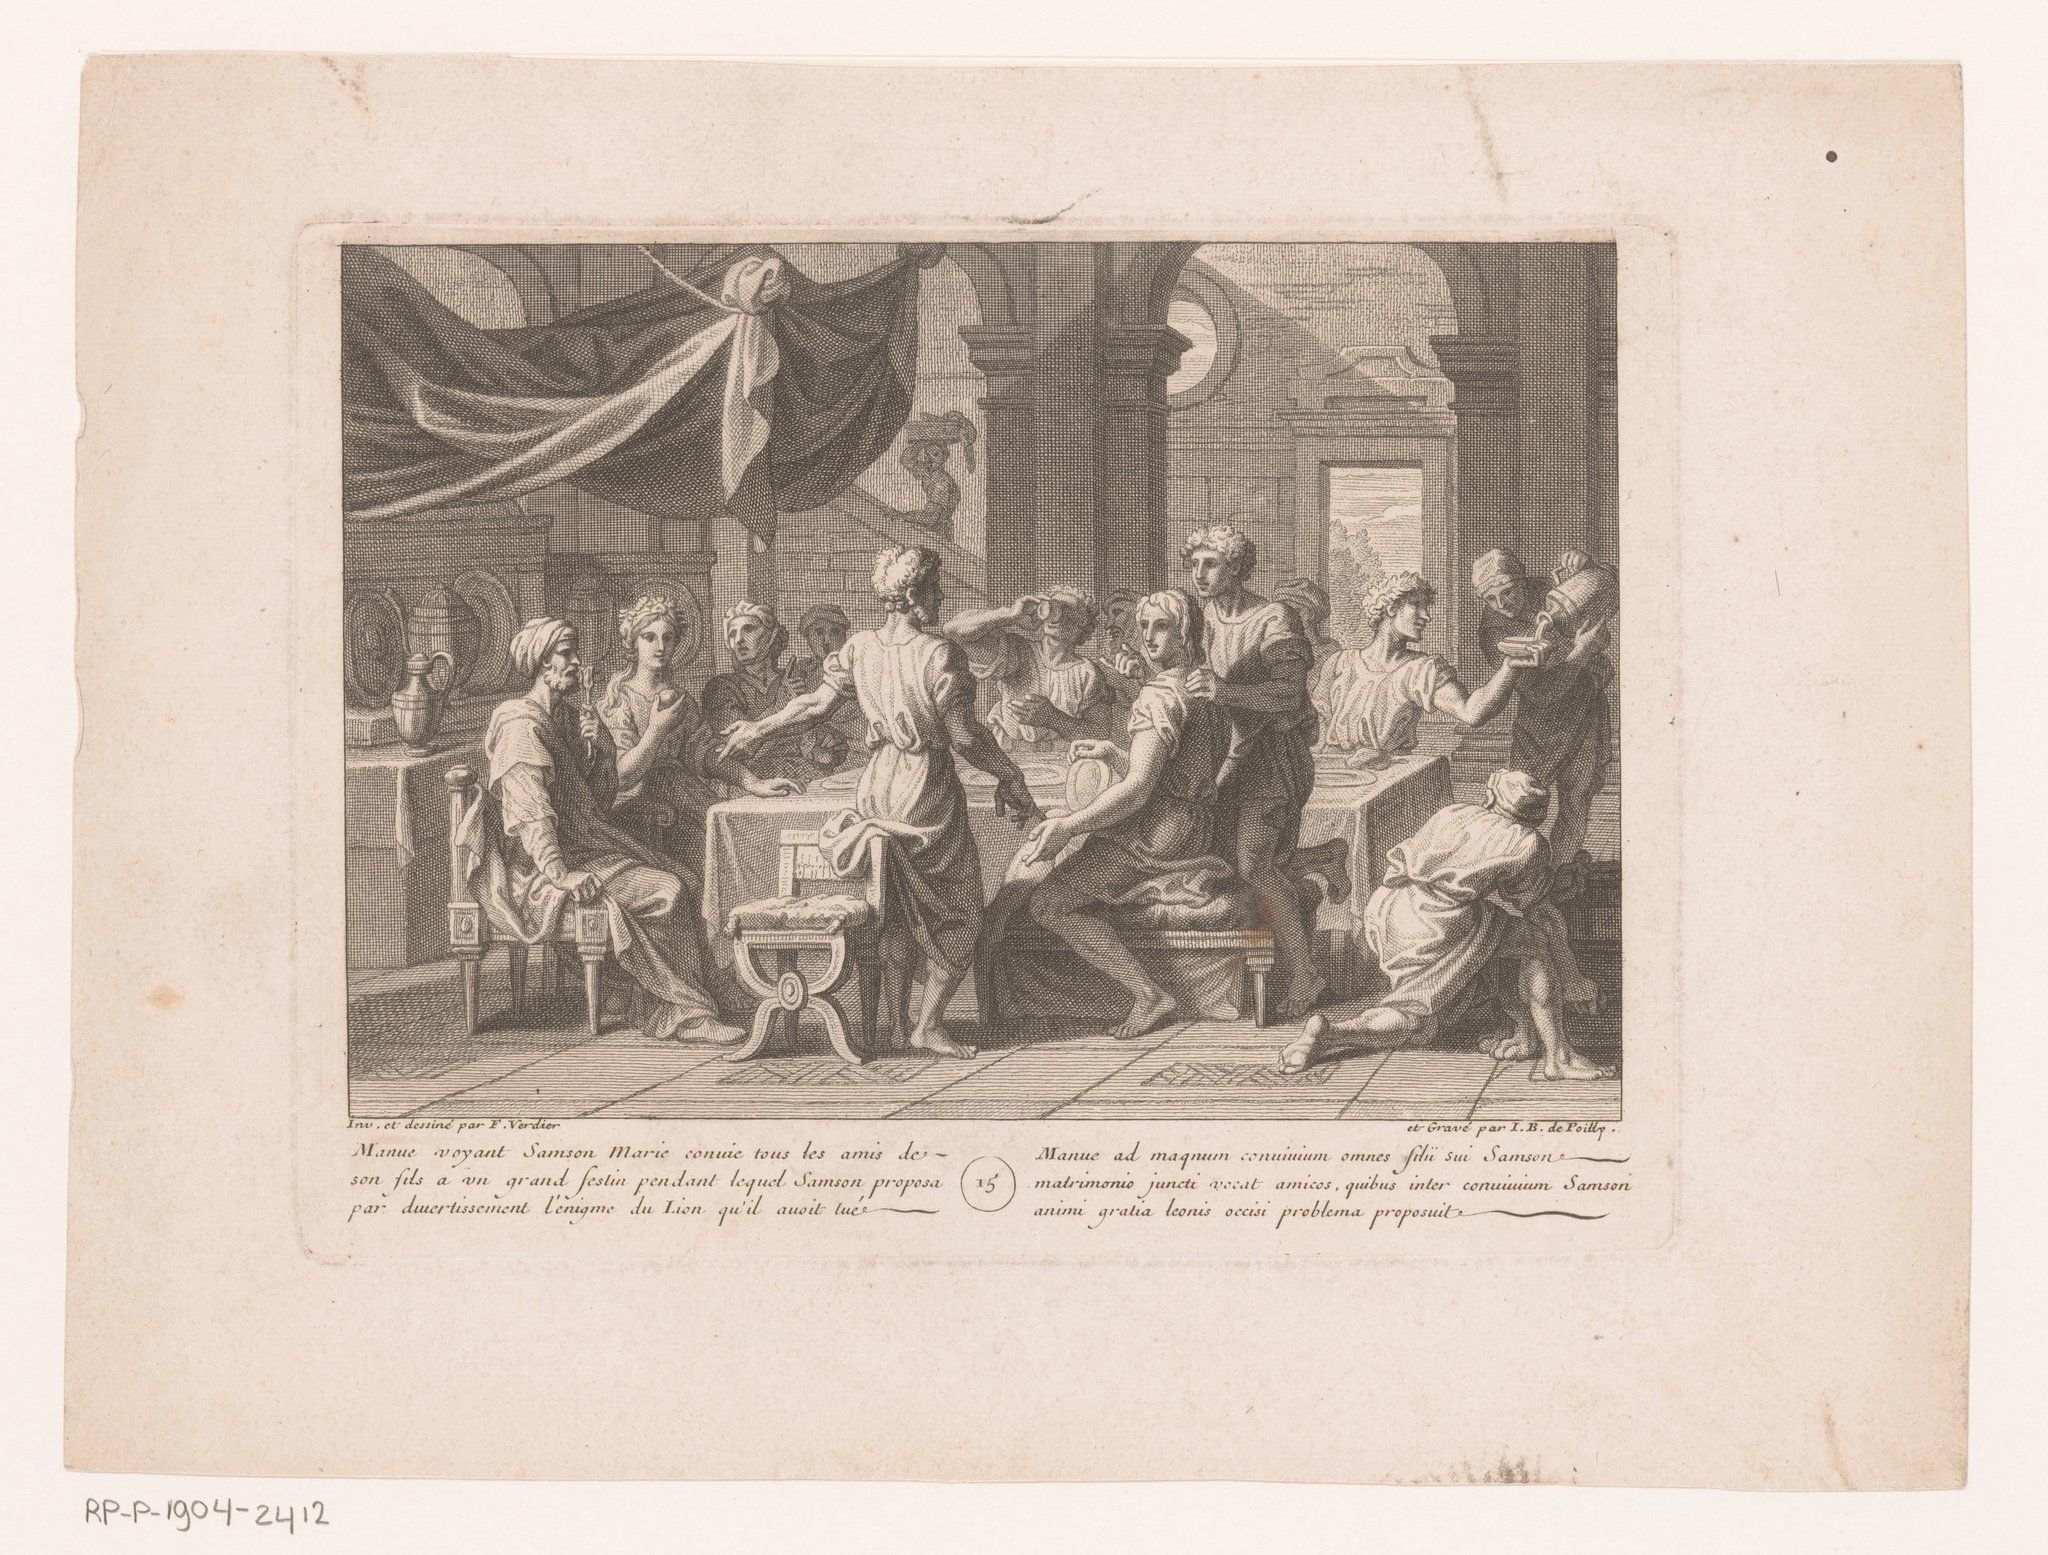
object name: print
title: Leven van Samson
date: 1679-1728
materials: paper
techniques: etching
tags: the time of samson ~ the book of judges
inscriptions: collector's mark: Lugt 2228